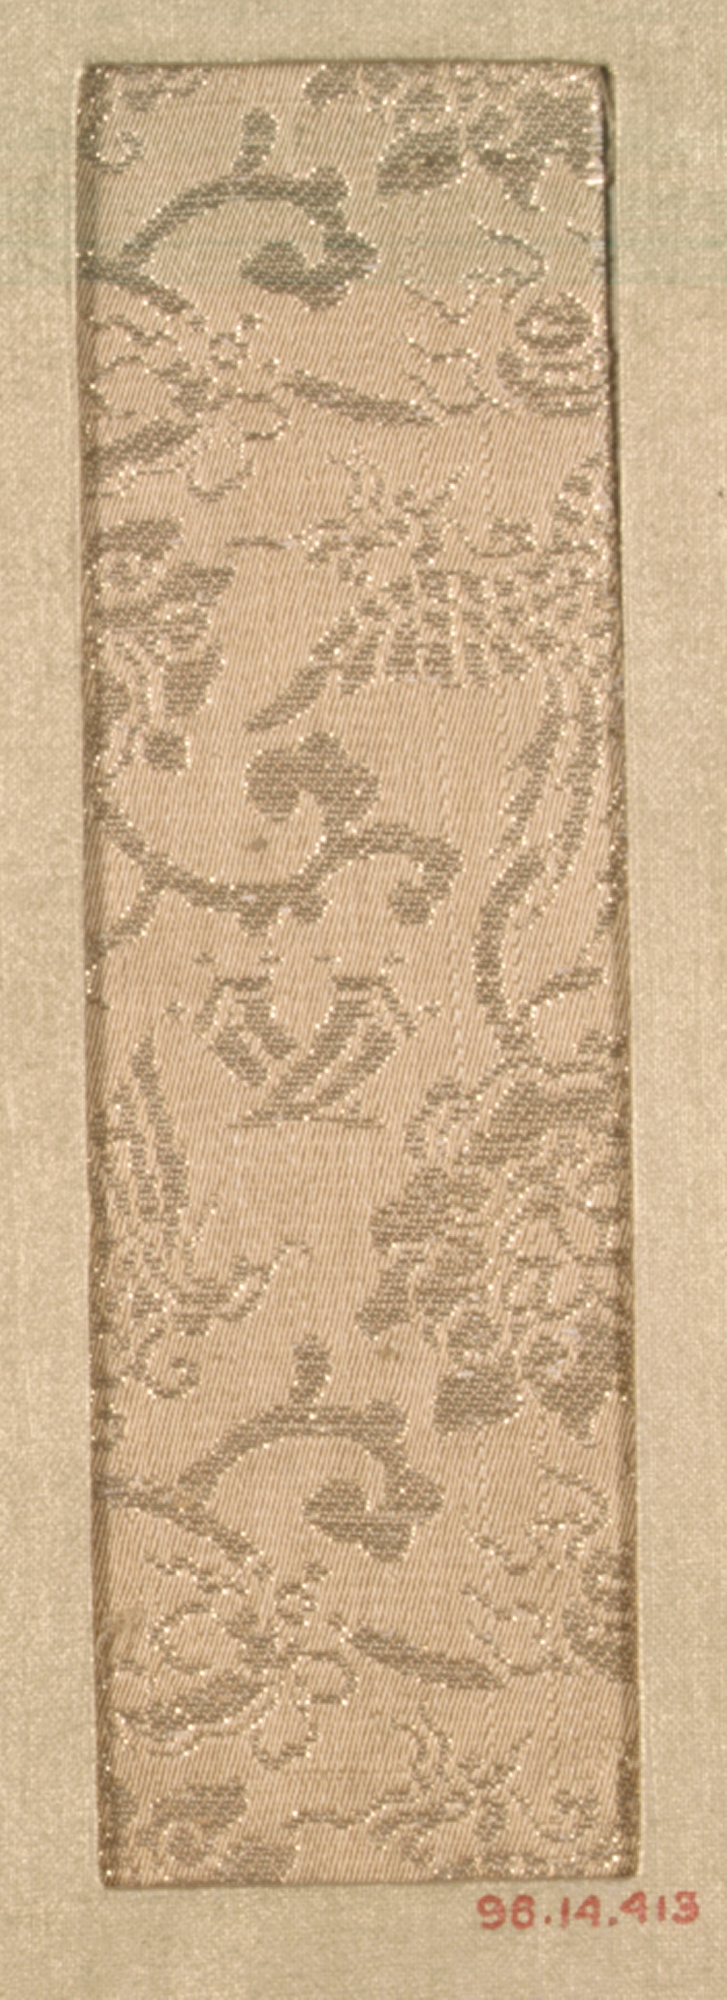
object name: piece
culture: japanese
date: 1701-1900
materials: silk